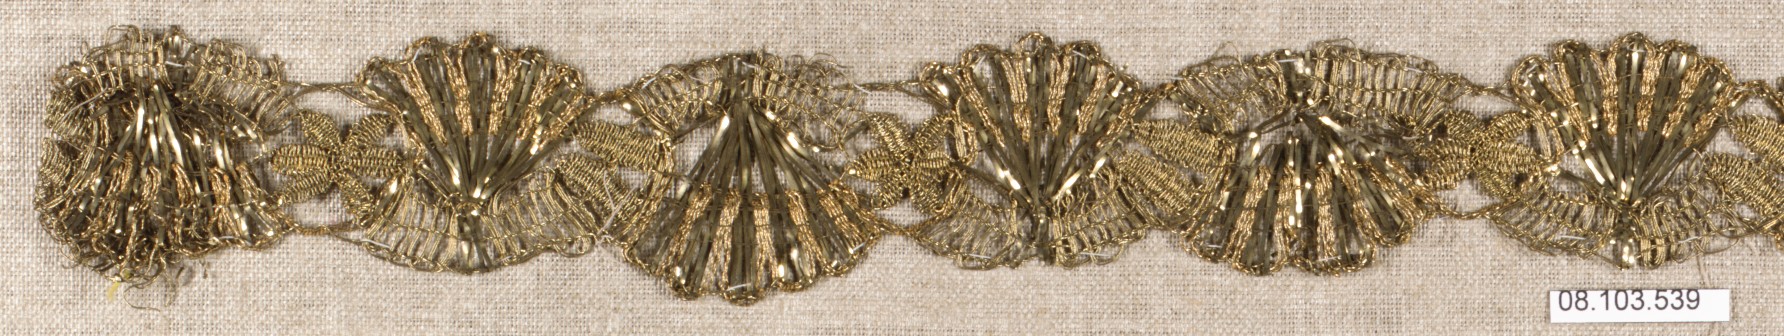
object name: galloon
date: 1701-1800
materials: metal thread